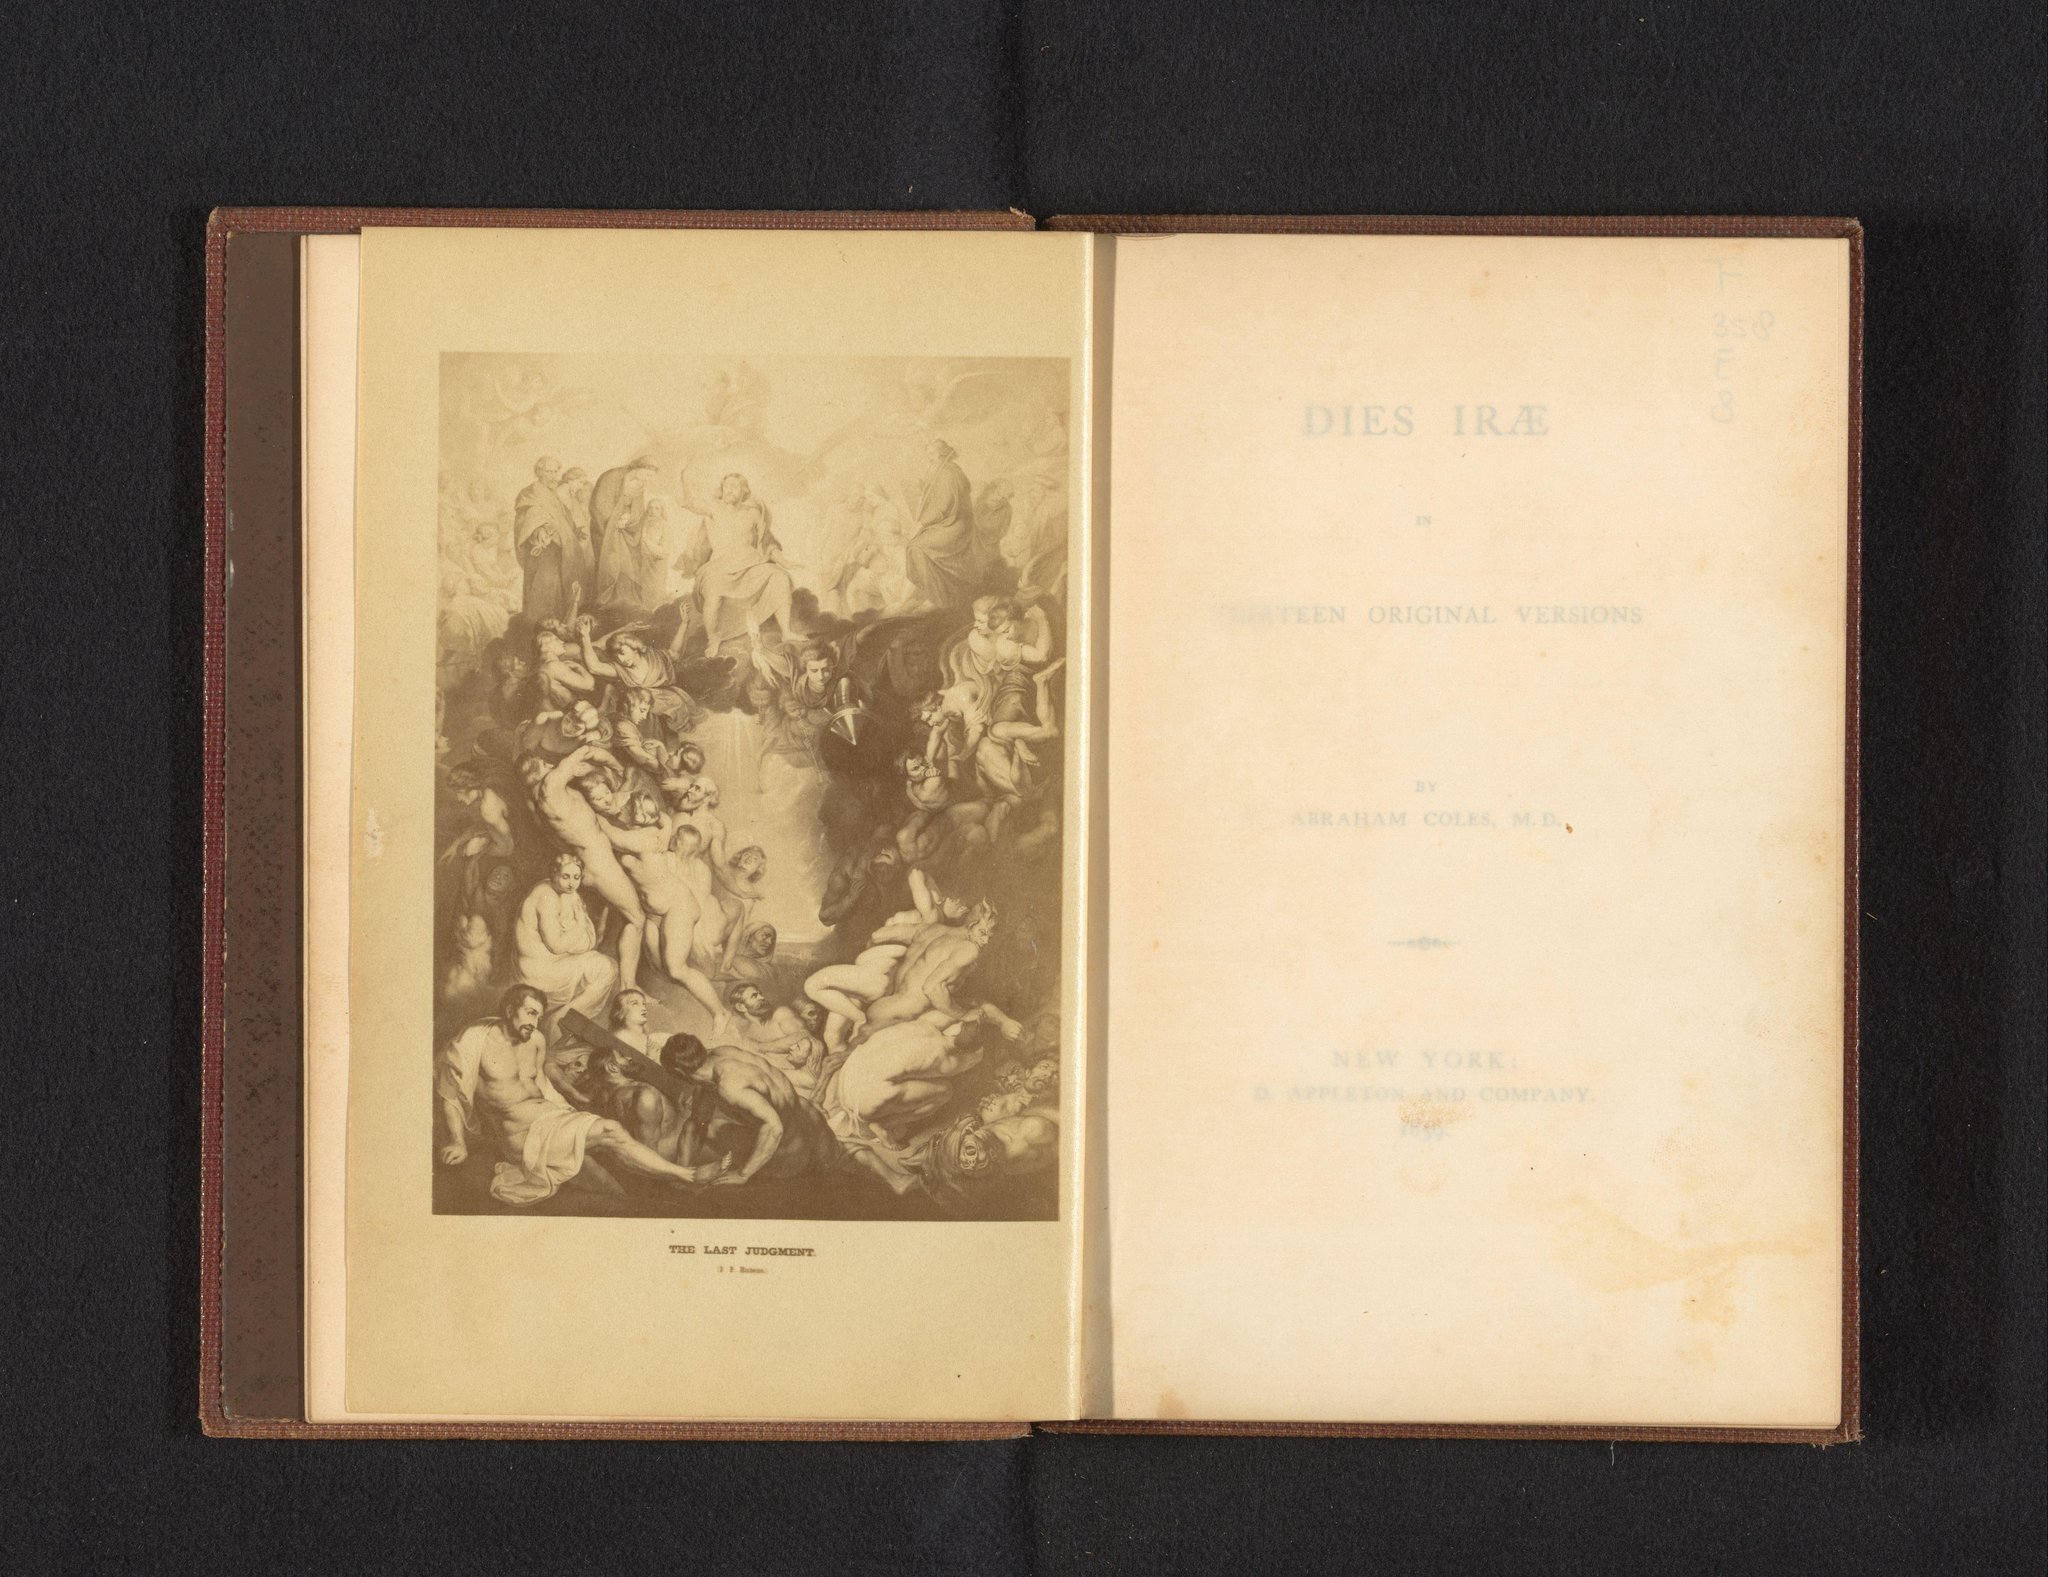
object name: page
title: The Last Judgment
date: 1854-1859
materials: photographic support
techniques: albumen print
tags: last judgement